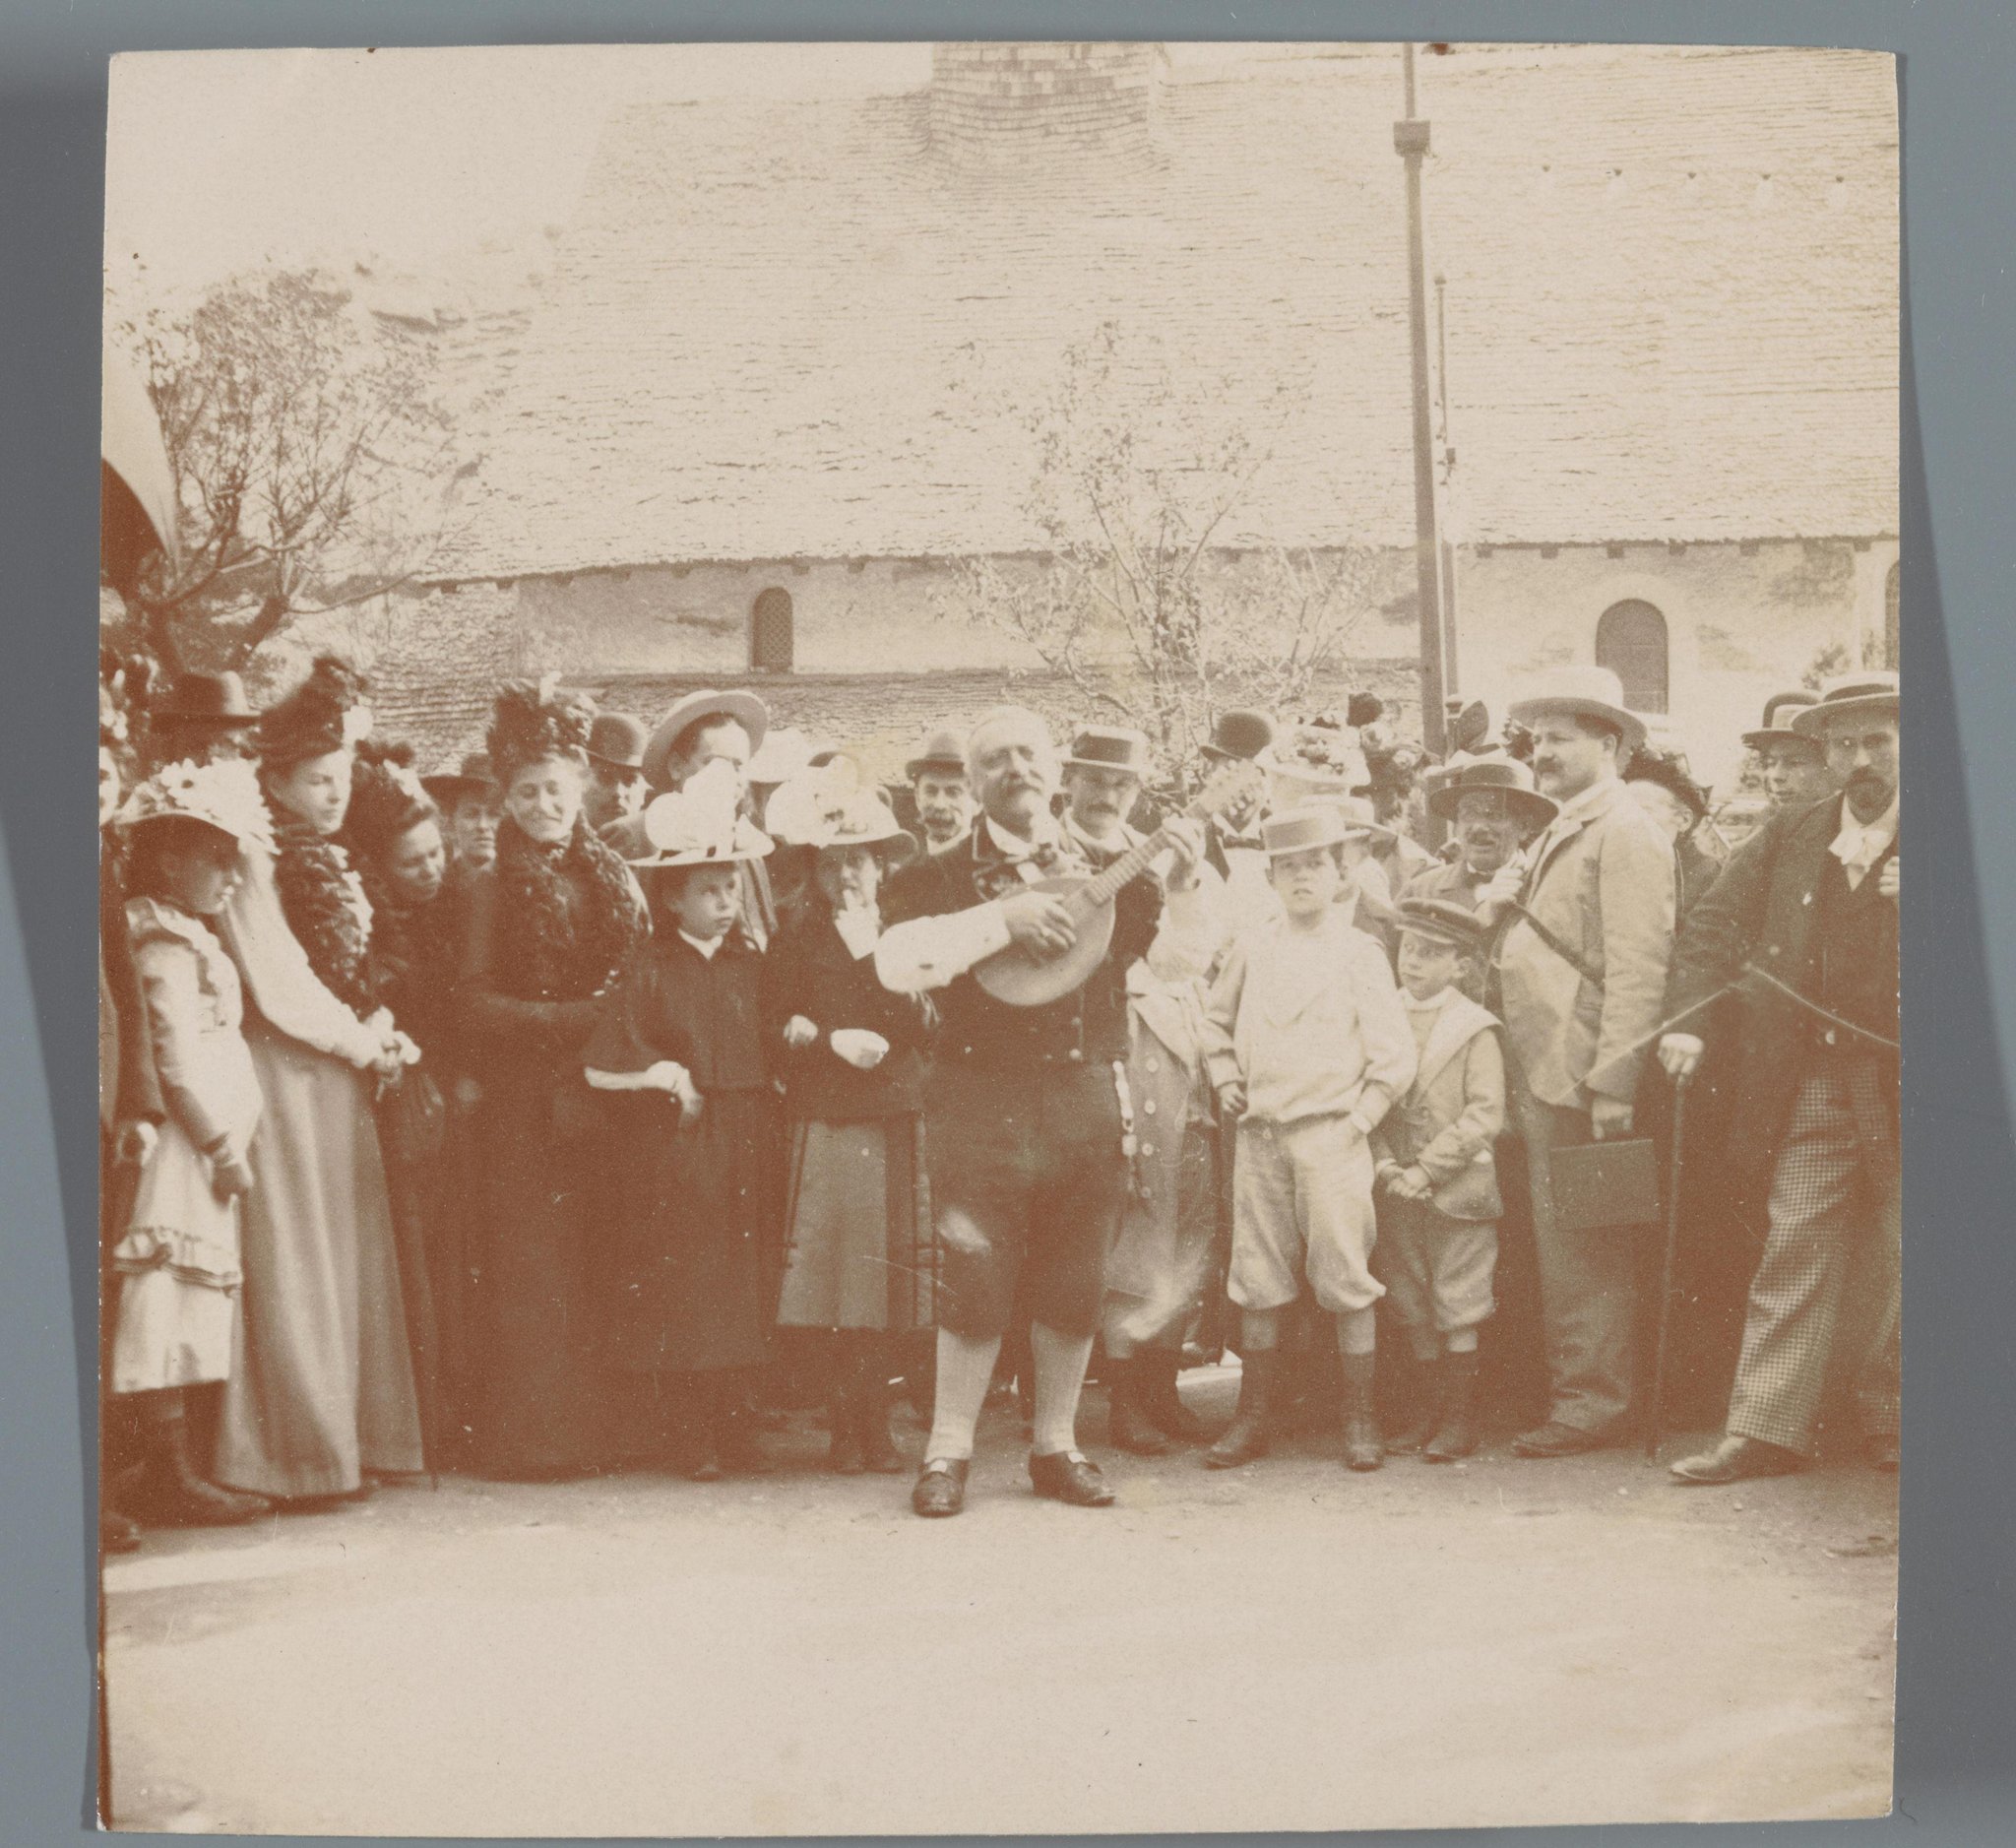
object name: photograph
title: Muzikant met luit (?), Frankrijk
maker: Anonymous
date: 1900-1903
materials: paper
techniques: gelatin silver print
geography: france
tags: public festivities, instrumental popular music - cc - out of doors, france